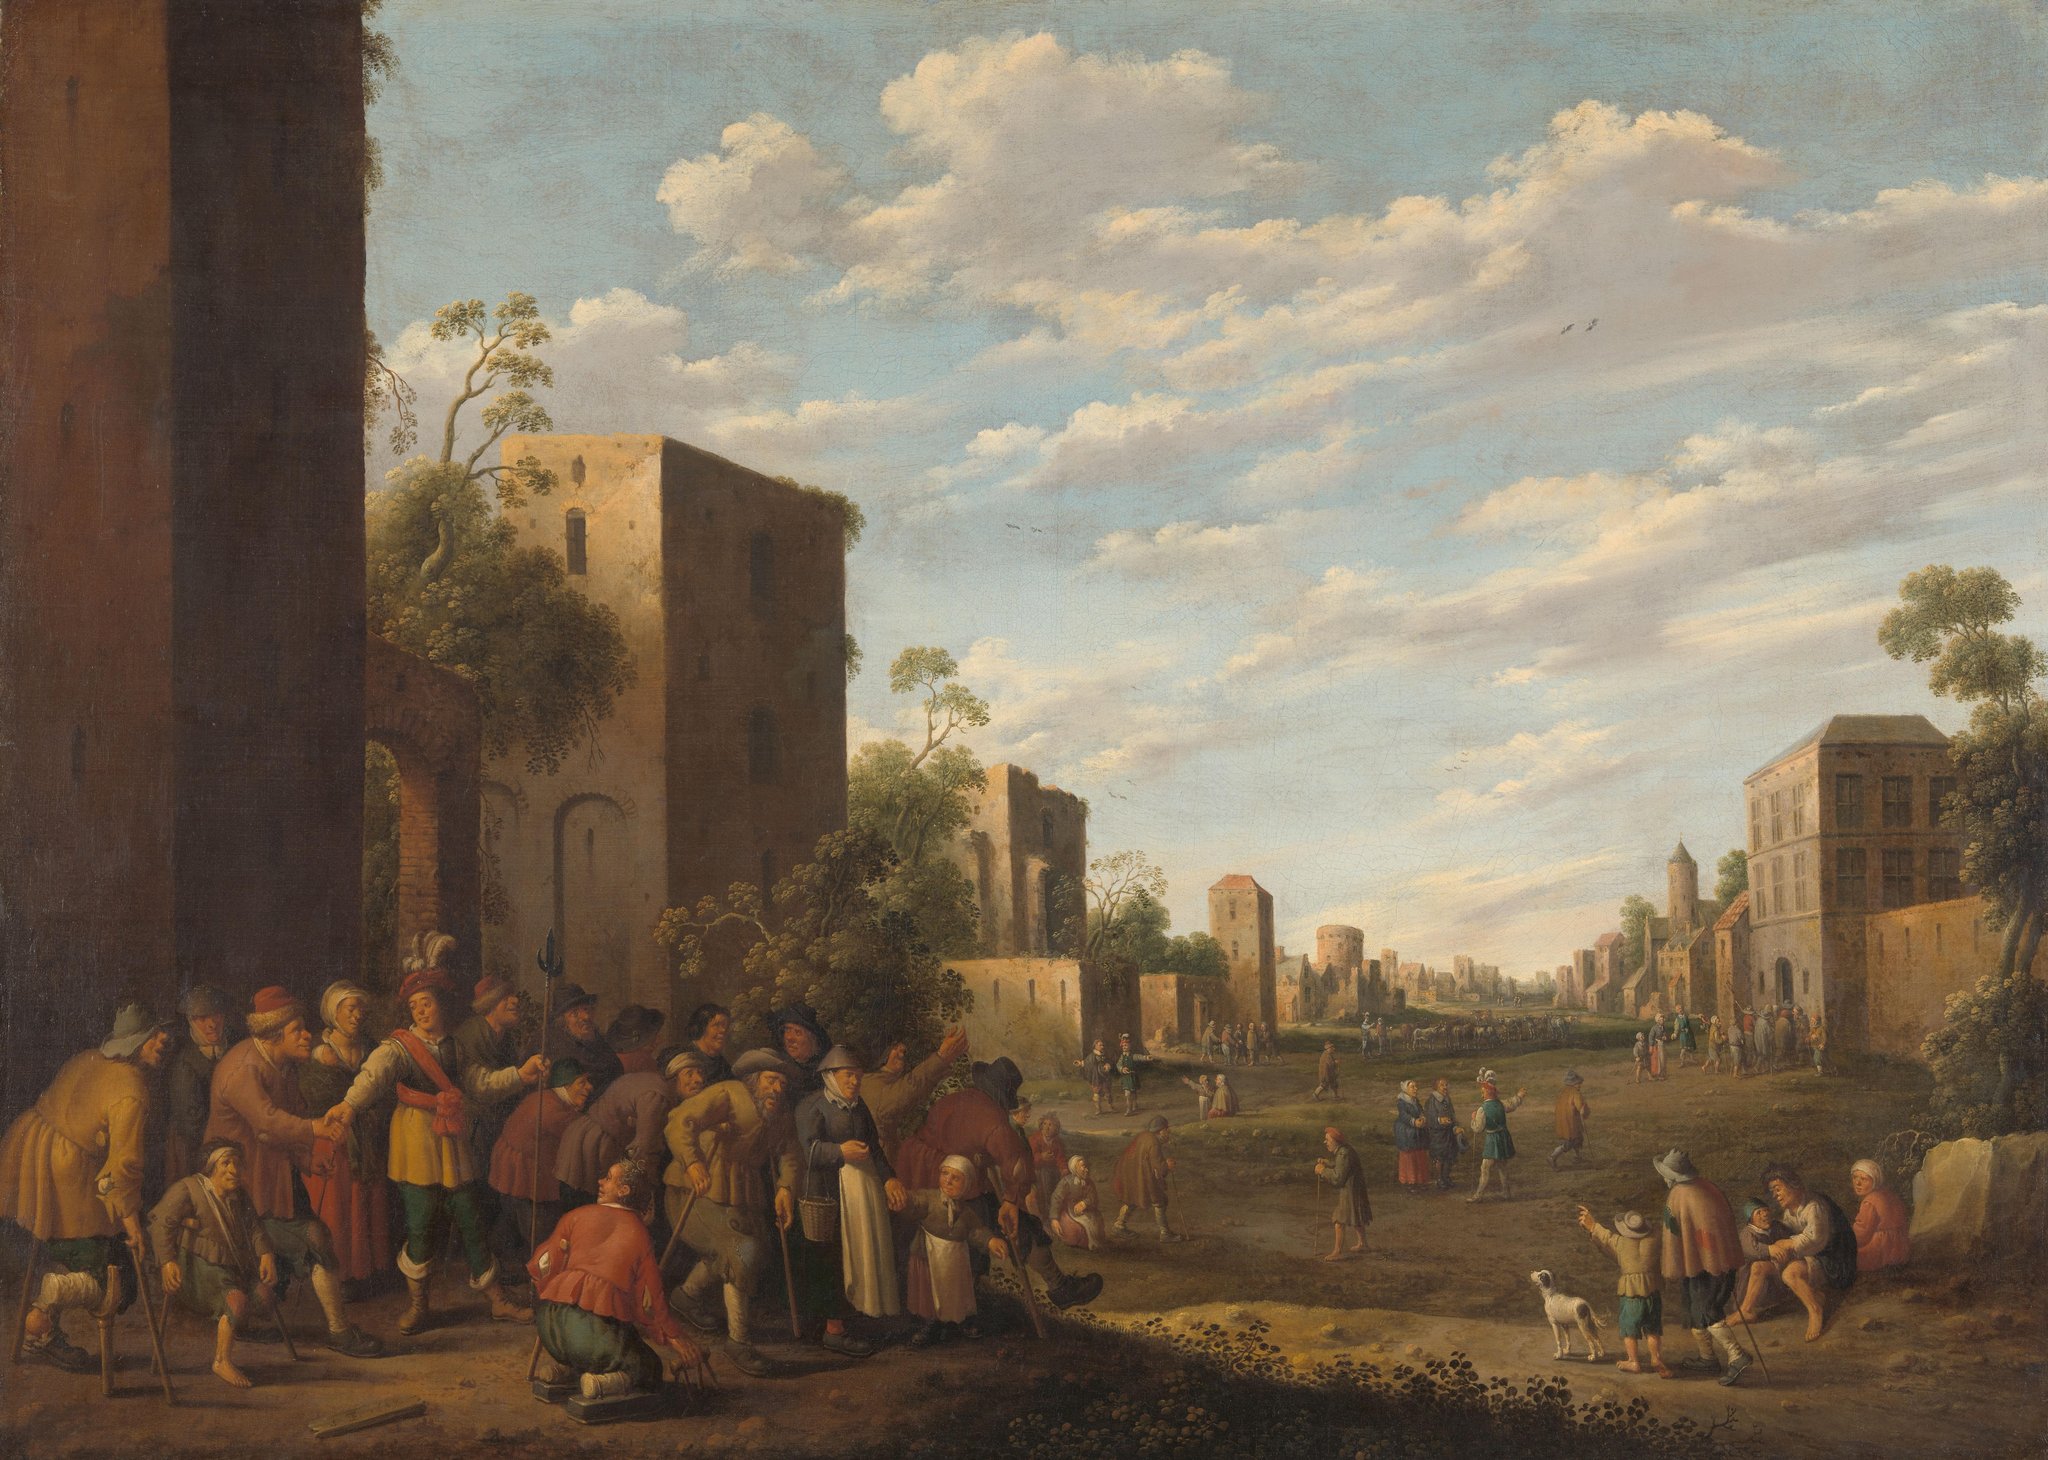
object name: painting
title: Housing the Poor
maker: joost cornelisz droochsloot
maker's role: painter, print maker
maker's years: 1585-1666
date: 1647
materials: canvas, oil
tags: sheltering strangers, 'hospes colligitur' ~ one of the (seven) acts of mercy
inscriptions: signature and date, lower left, on the piece of wood (J and C ligated, D and S ligated): ‘JC. DS. 1647’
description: Het huisvesten van de armen. Een brede weg met aan weerszijden Italiaanse gebouwen. Verschillende jonge mannen met hoeden met pluimen wijzen groepen bedelaars naar een huis aan de rechterkant van de weg waar zij onderdak kunnen krijgen.